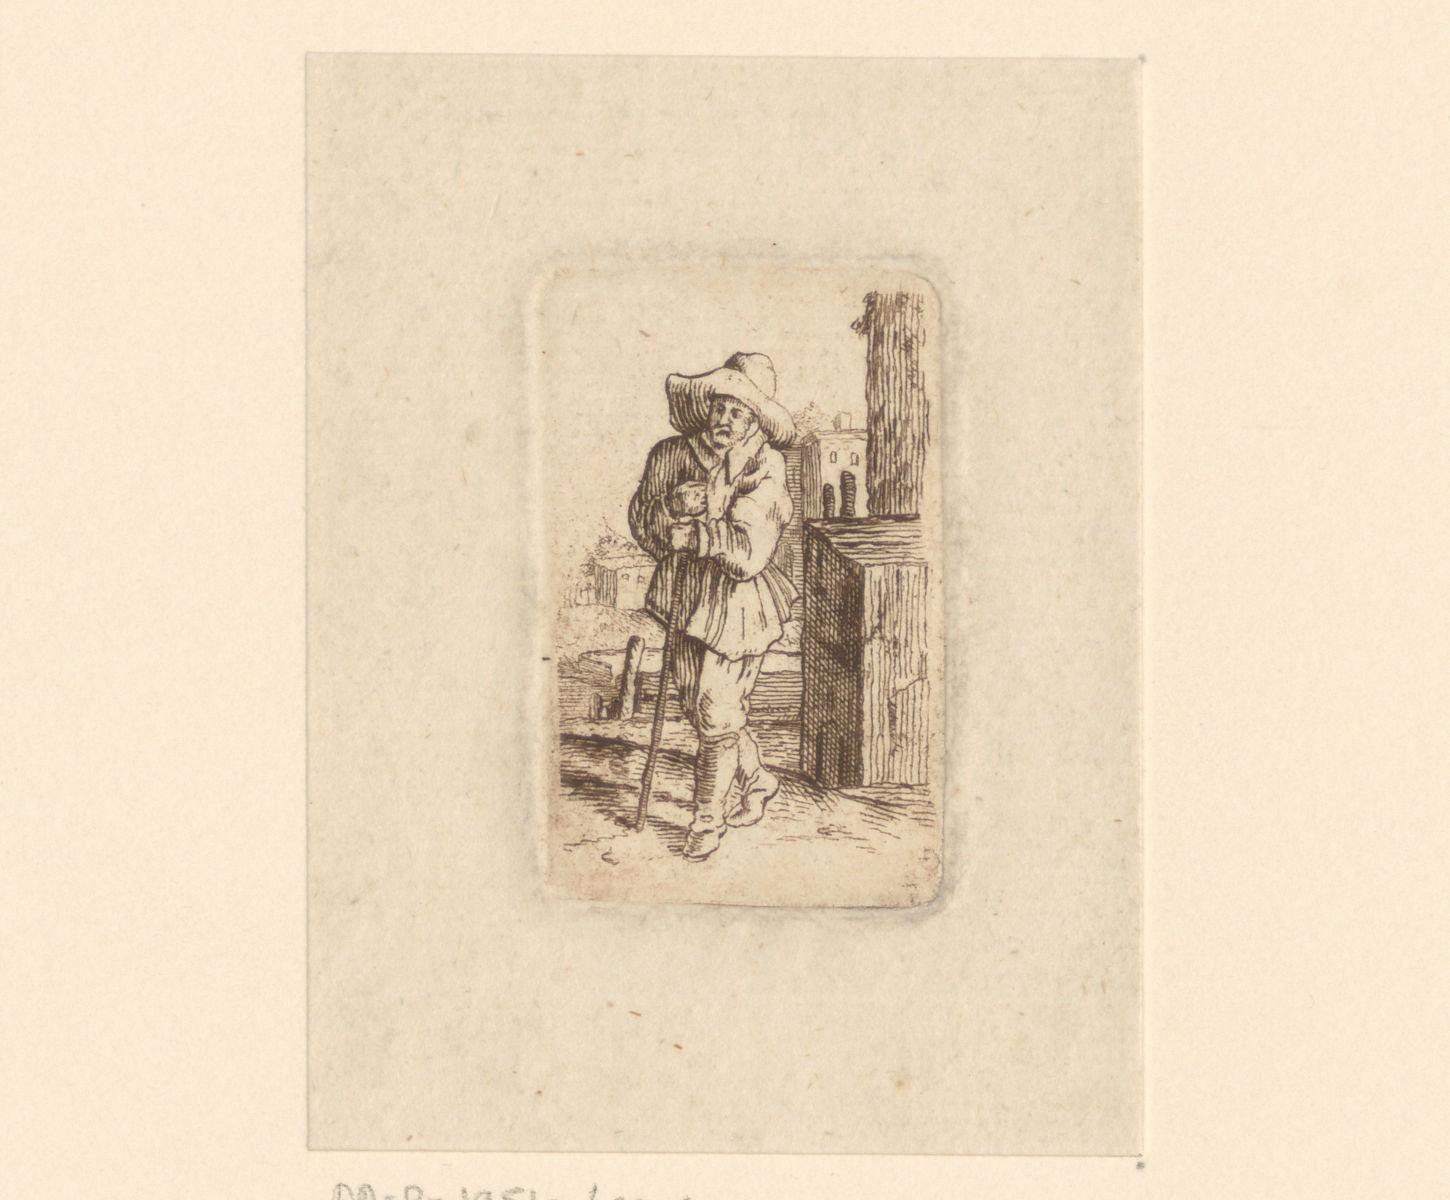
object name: print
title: Figuren met verschillende beroepen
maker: paul sandby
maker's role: draughtsman, print maker, publisher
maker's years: 1725-1809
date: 1735-1809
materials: paper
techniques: etching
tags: adult man, persons engaged in trade and commerce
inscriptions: collector's mark: Lugt 2228